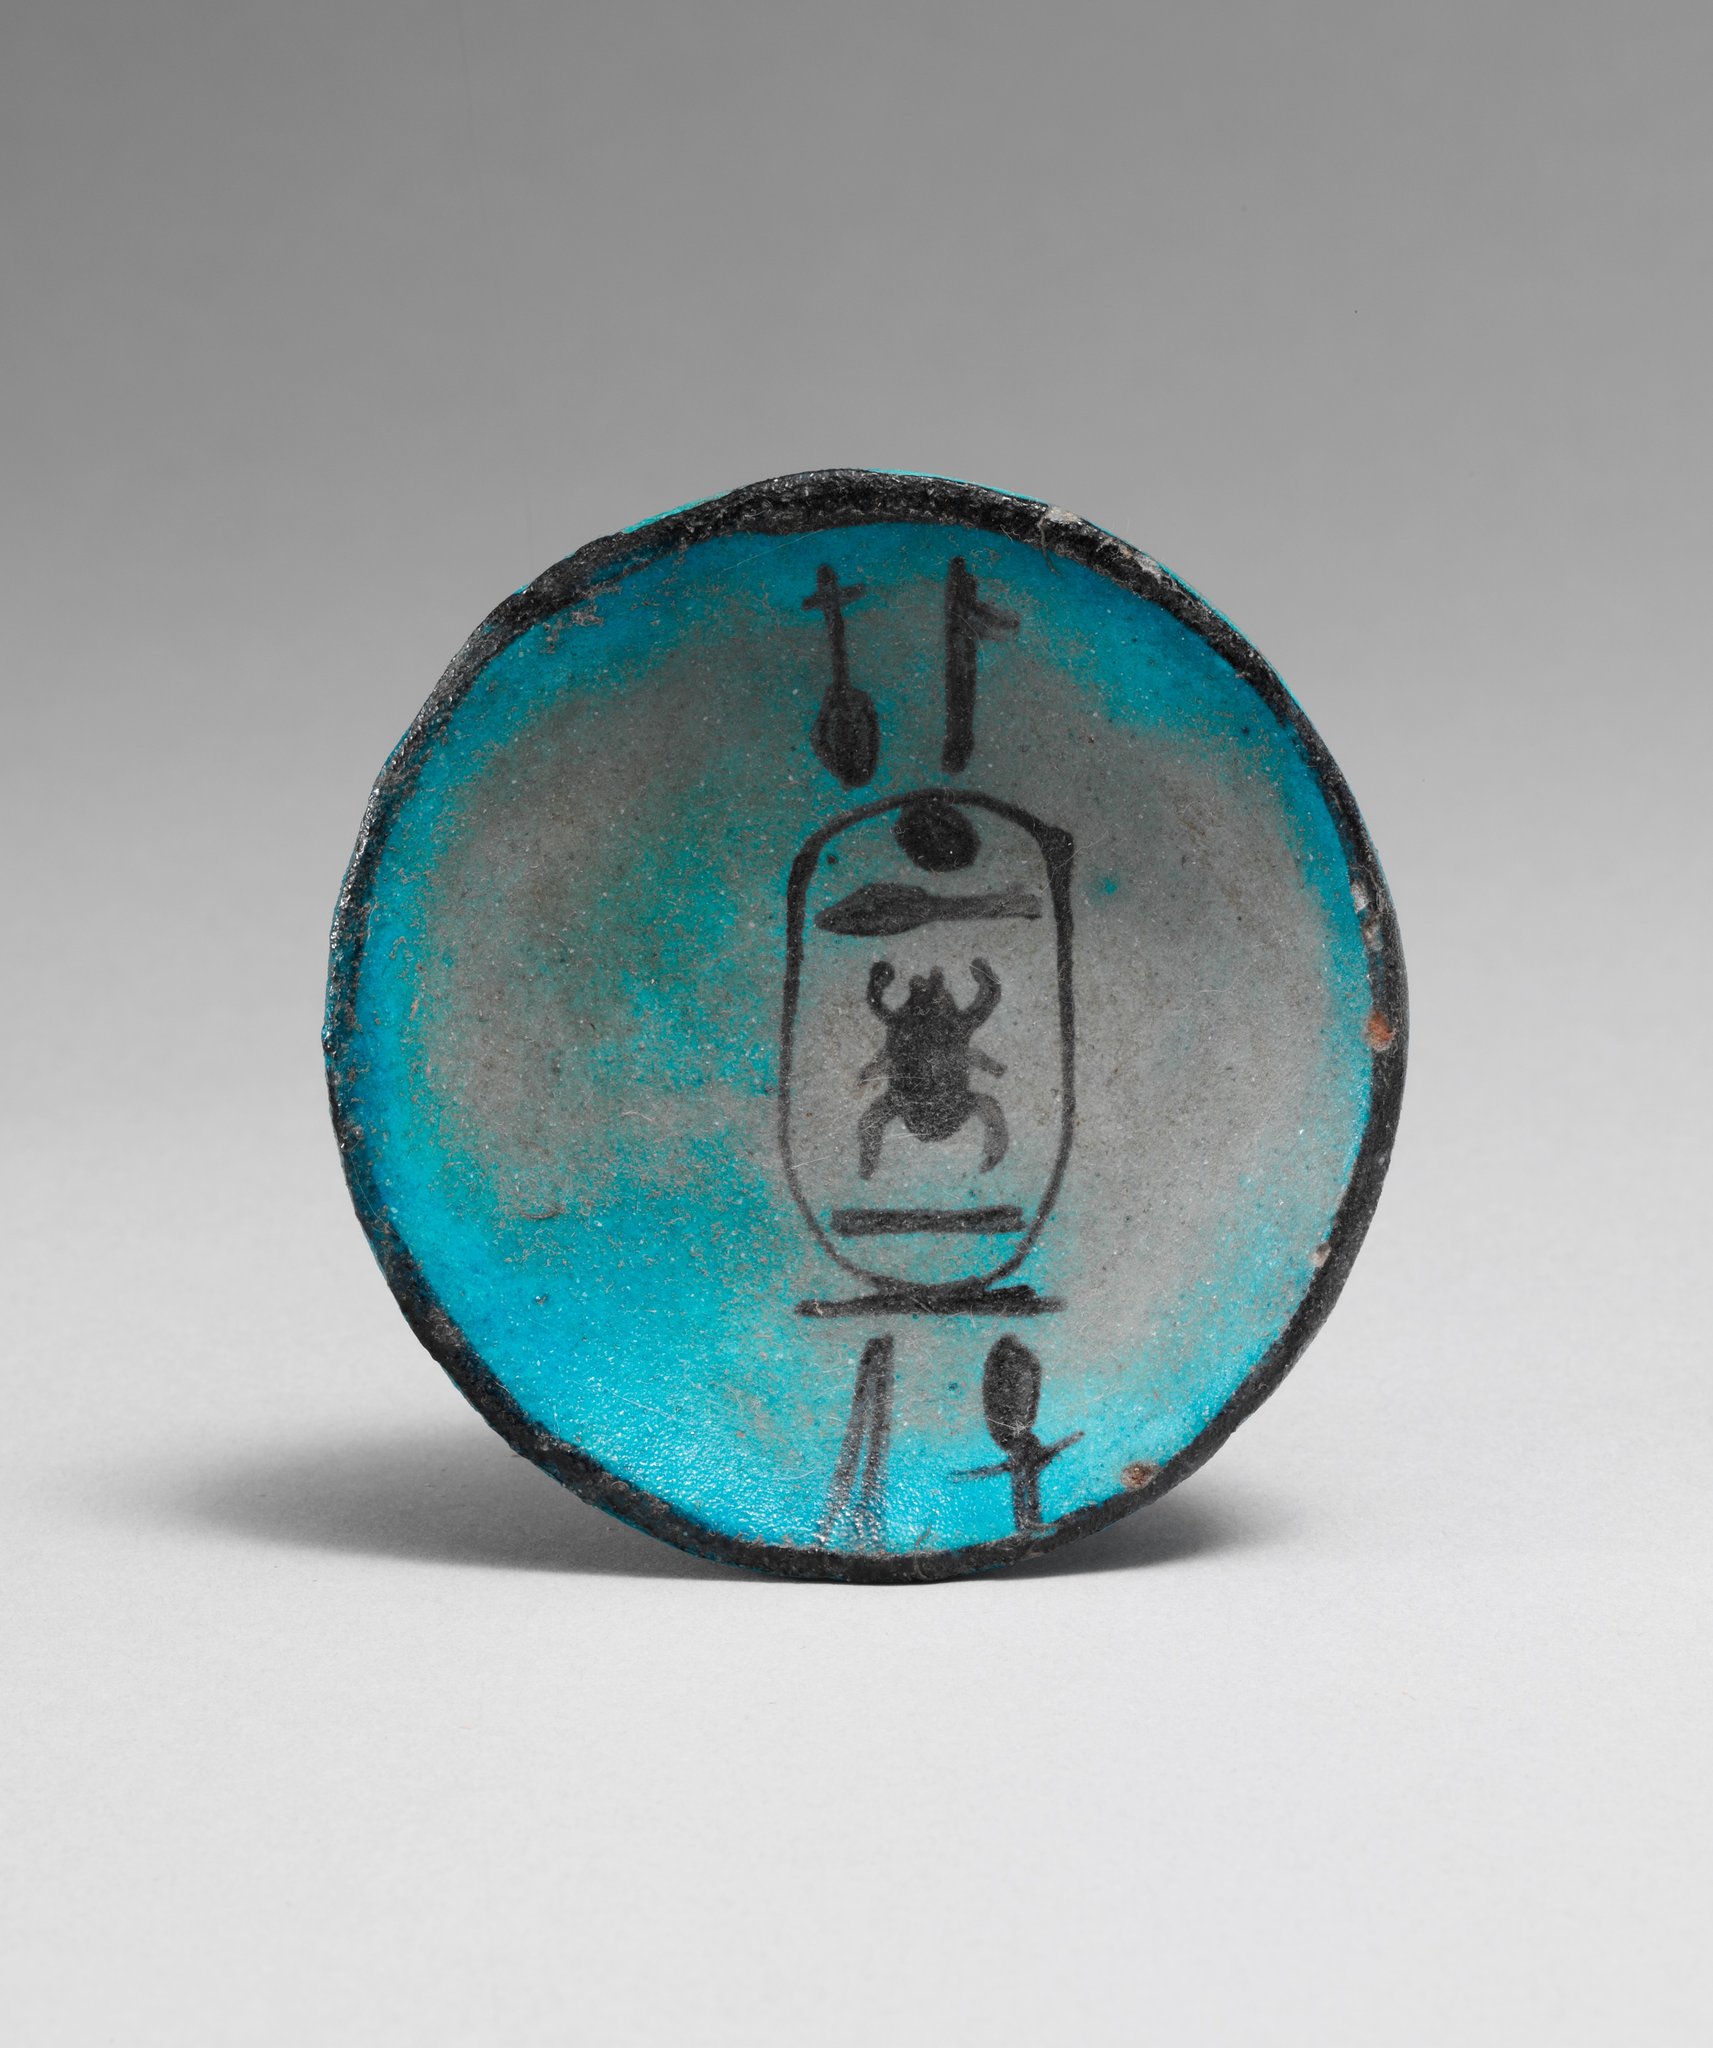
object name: dish, thutmose ii, hatnefer, aakheperenre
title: Dish Inscribed with the Throne Name of Thutmose II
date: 1492-1473 BCE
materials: faience, paint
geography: egypt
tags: cartouches